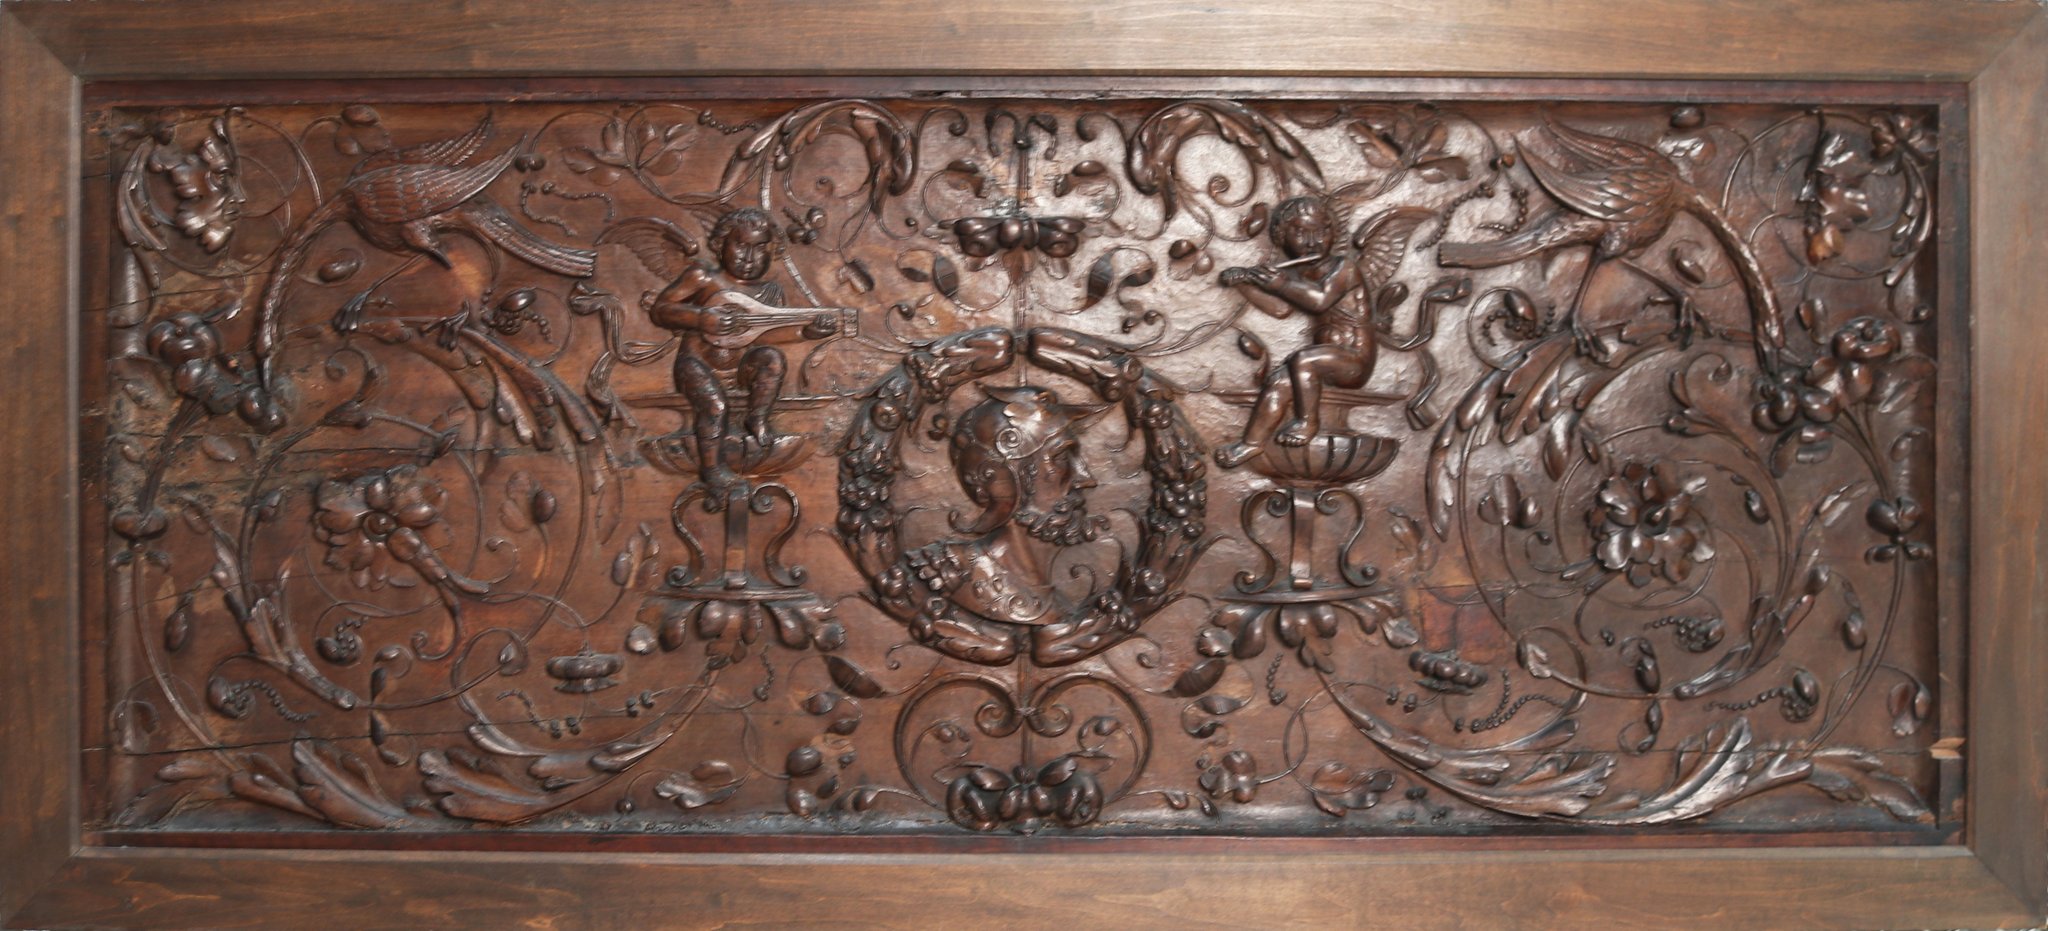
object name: panel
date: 1530-1550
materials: wood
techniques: carving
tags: musical instruments,birds,men,profiles,putti